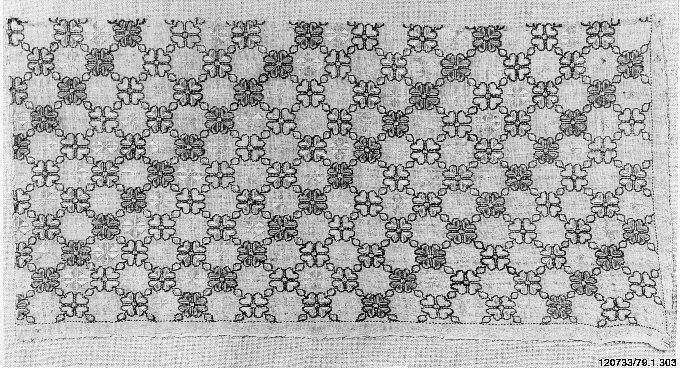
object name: textile fragment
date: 1801-1833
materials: linen, silk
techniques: embroidery, weave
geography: greece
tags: flowers